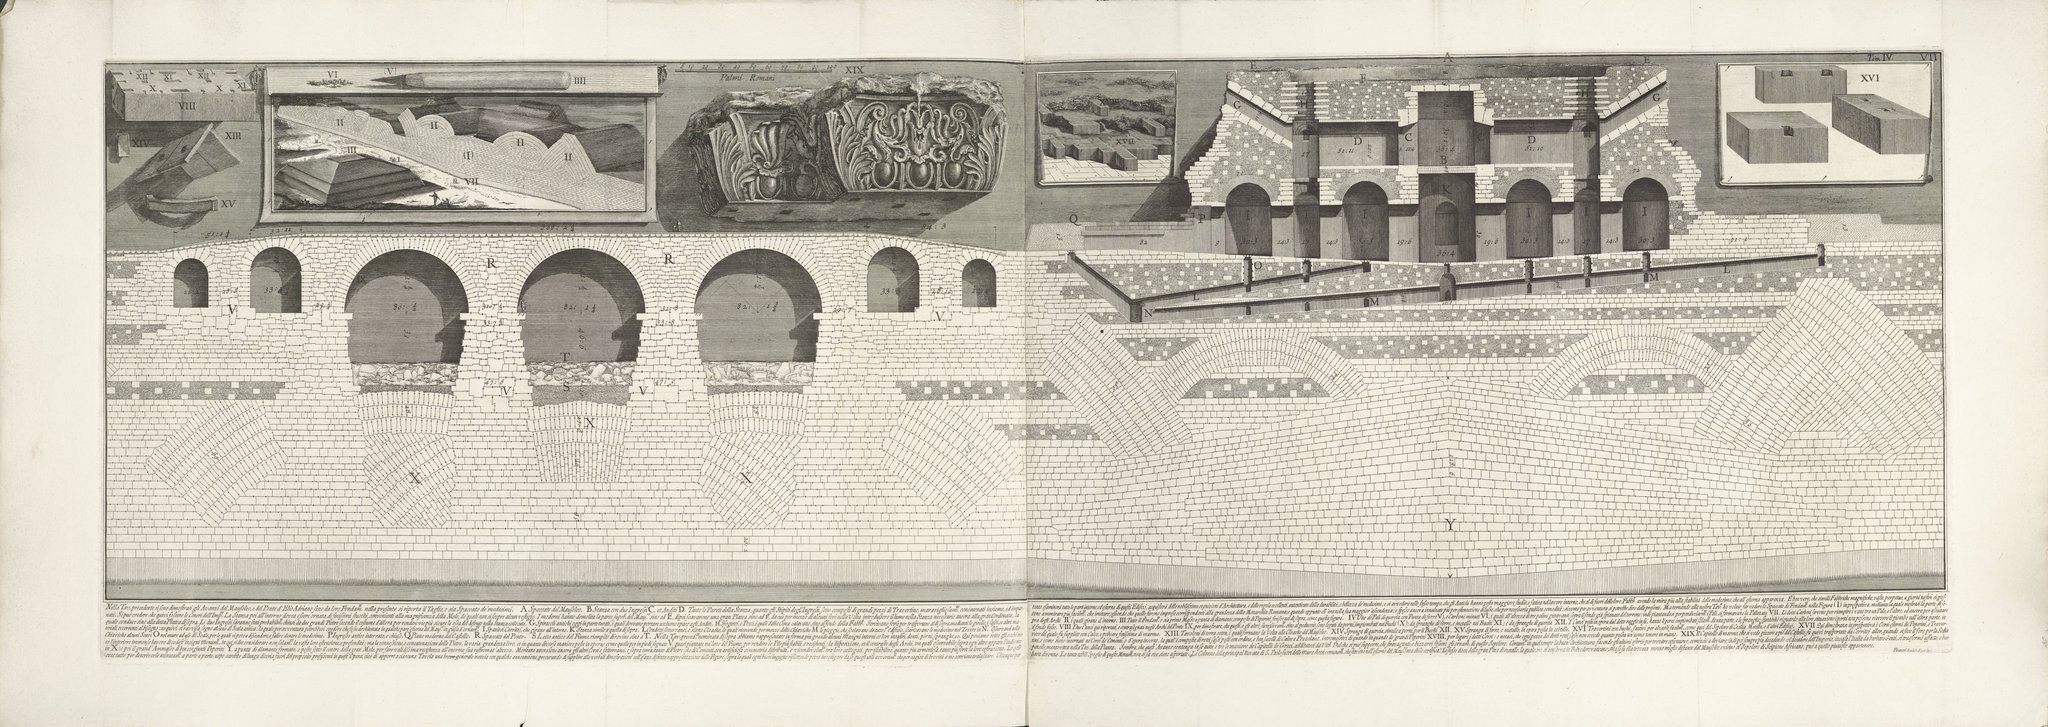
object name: print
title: Nella Tav. precedente si sono dimostrati gli Avanzo del Mausoleo (...)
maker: giovanni battista piranesi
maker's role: designer, draughtsman, print maker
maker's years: 1720-1778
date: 1756-1757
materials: paper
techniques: etching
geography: rome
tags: mausoleum, bridge, rome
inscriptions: collector's mark: Lugt 2228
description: Deze prent maakt deel uit van de serie 'Le Antichità Romane'. Piranesi deed meer dan acht jaar voorstudie voor deze 250 platen tellende serie die in vier volumes werd uitgegeven. Hij produceerde de prenten tussen ca. 1756 en 1757. De serie bevat ook prenten door of naar andere prentmakers, onder wie Francesco Bianchini en Girolamo Rossi.